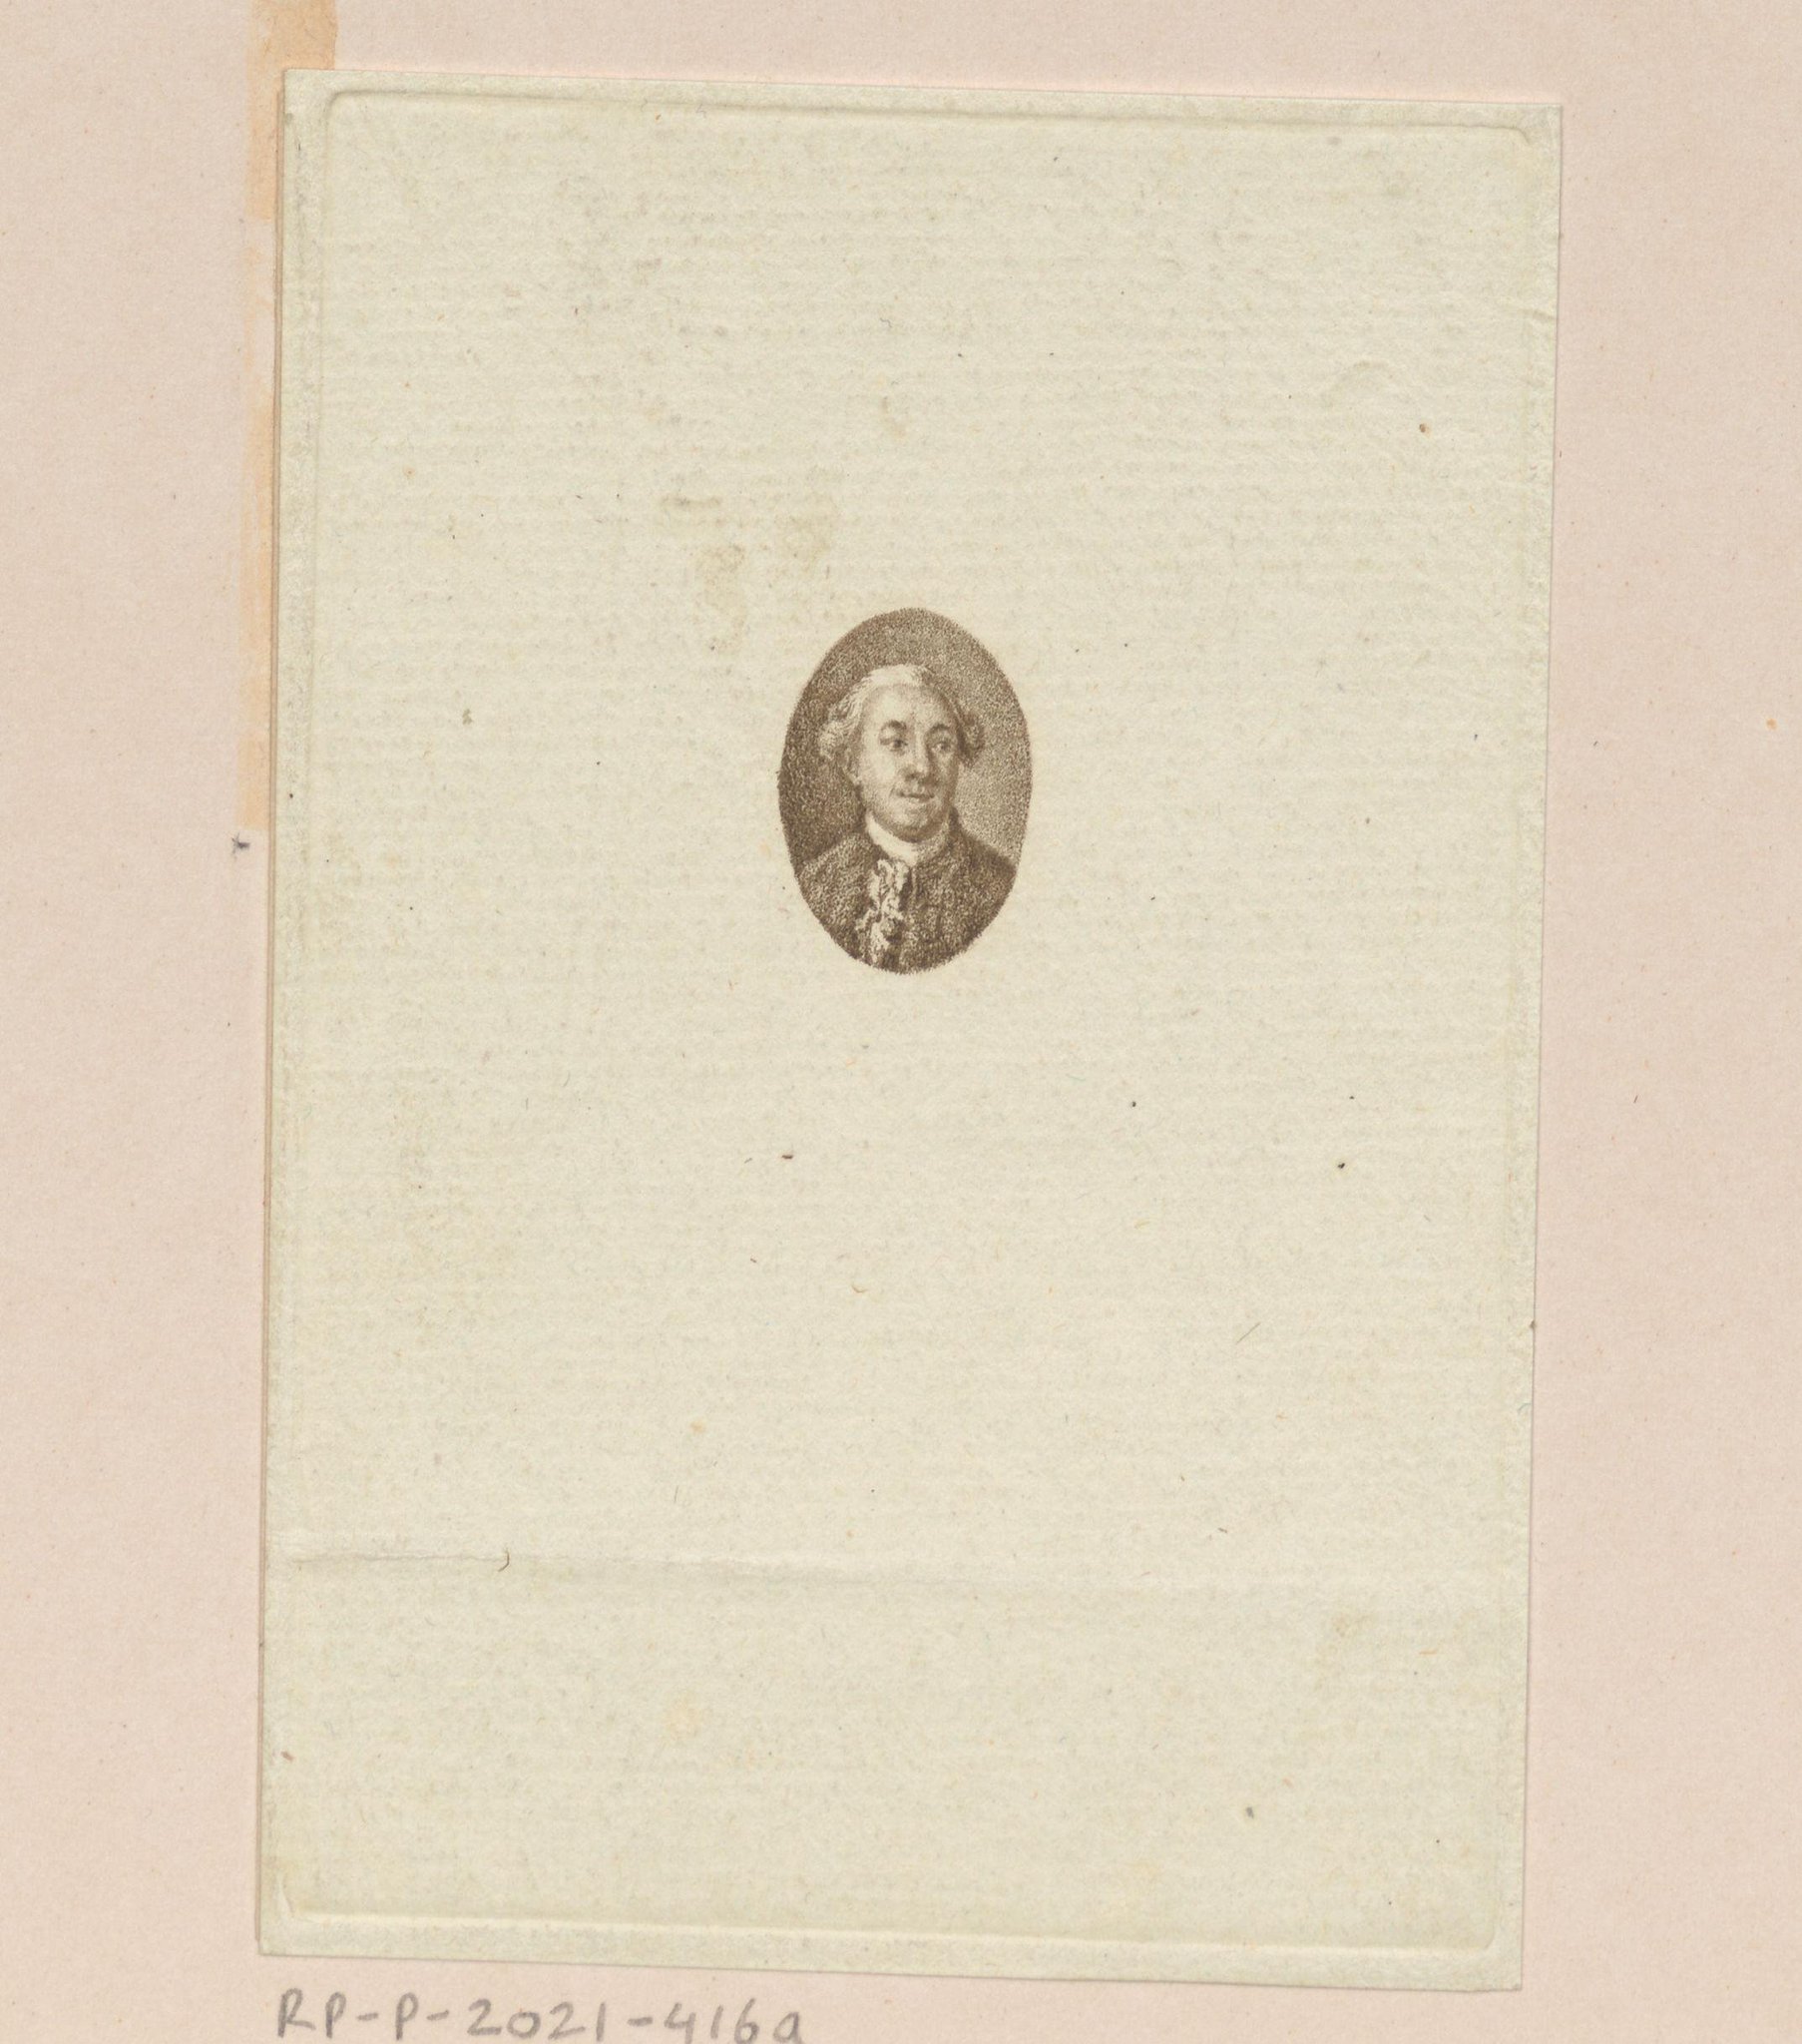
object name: print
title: Portret van Jacques Necker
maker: Anonymous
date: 1776-1799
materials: paper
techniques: stippling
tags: minister ~ government, historical persons